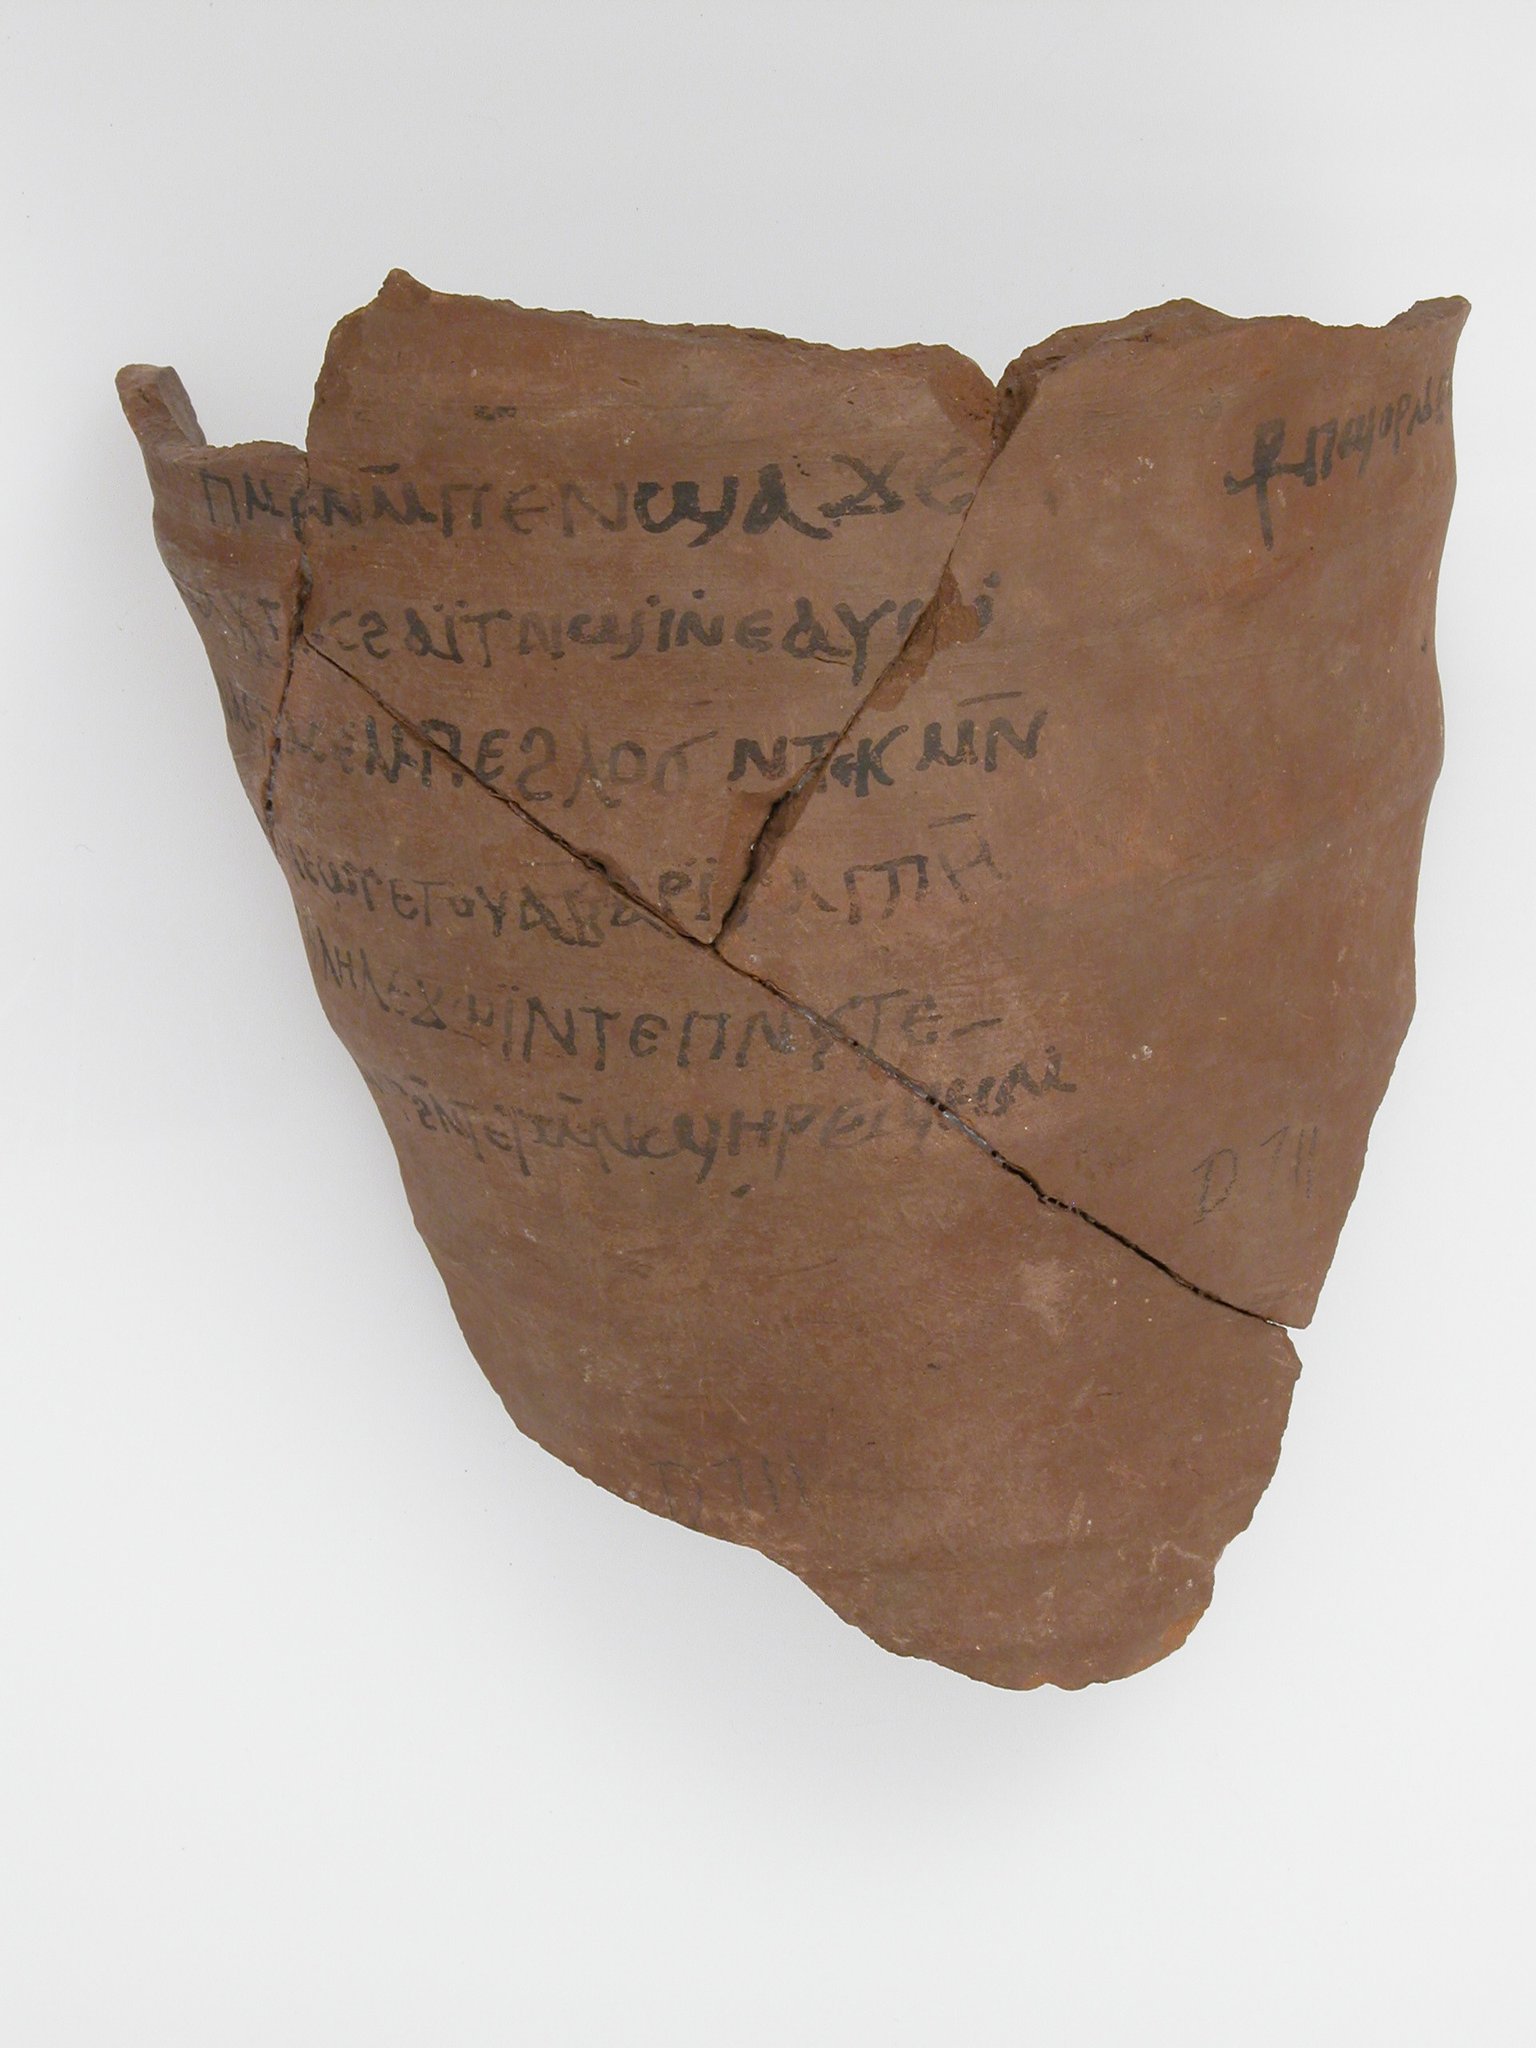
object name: ostrakon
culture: coptic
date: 601-700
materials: ink, pottery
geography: egypt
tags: documents